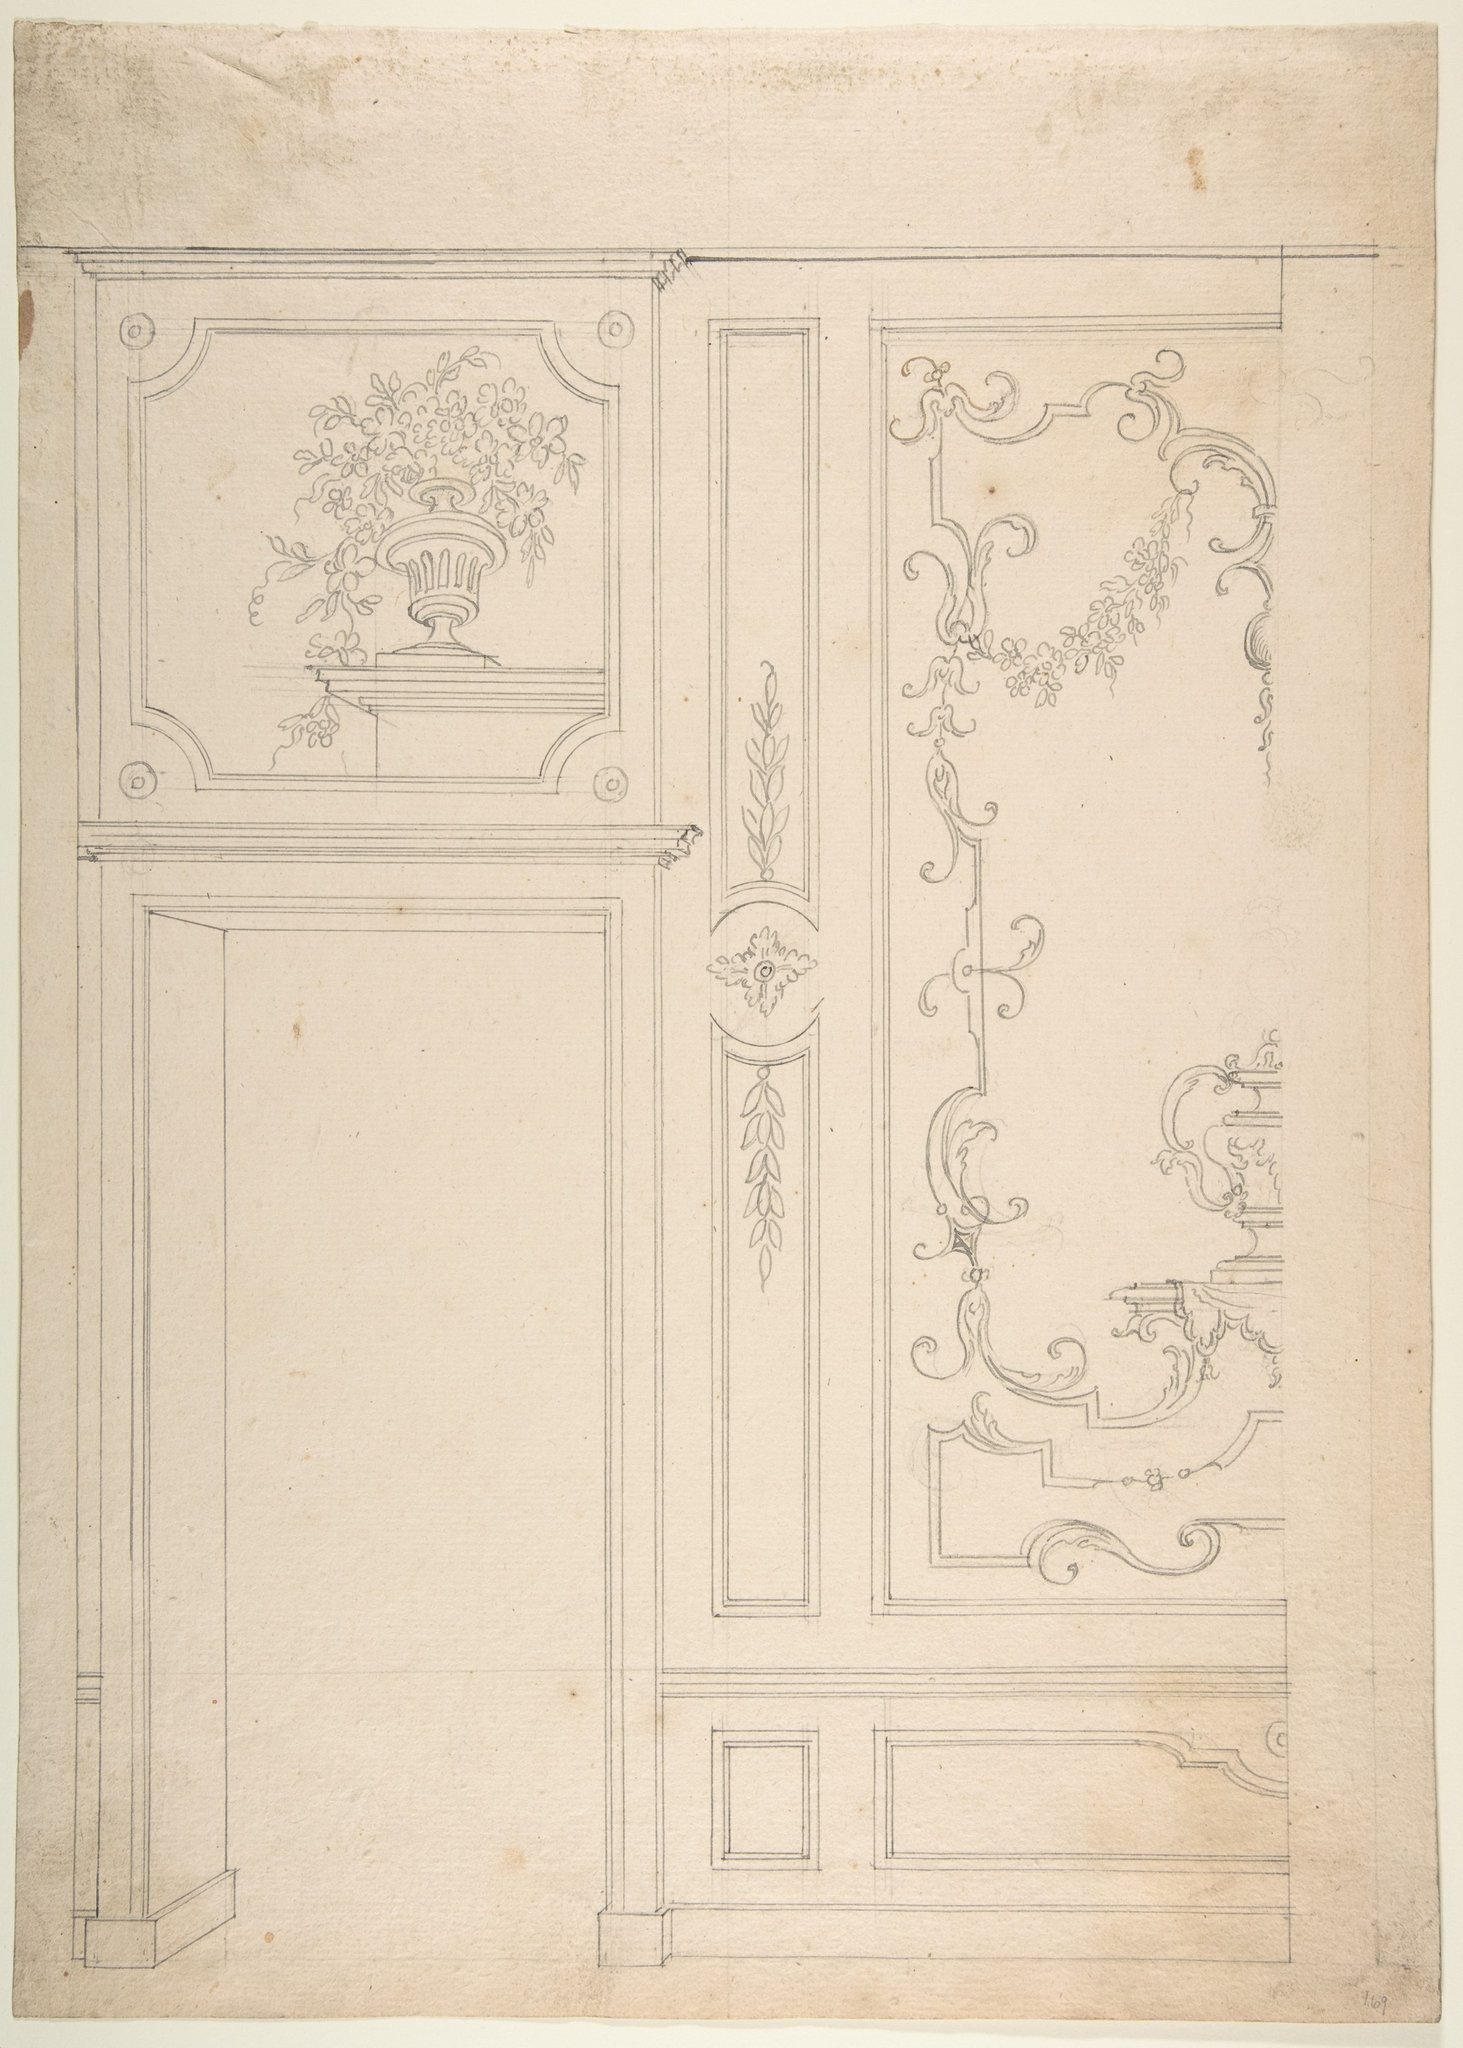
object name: drawing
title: Wall Design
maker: leonardo marini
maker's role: artist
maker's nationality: italian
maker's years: 1730-1797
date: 1701-1800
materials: graphite, drawing material